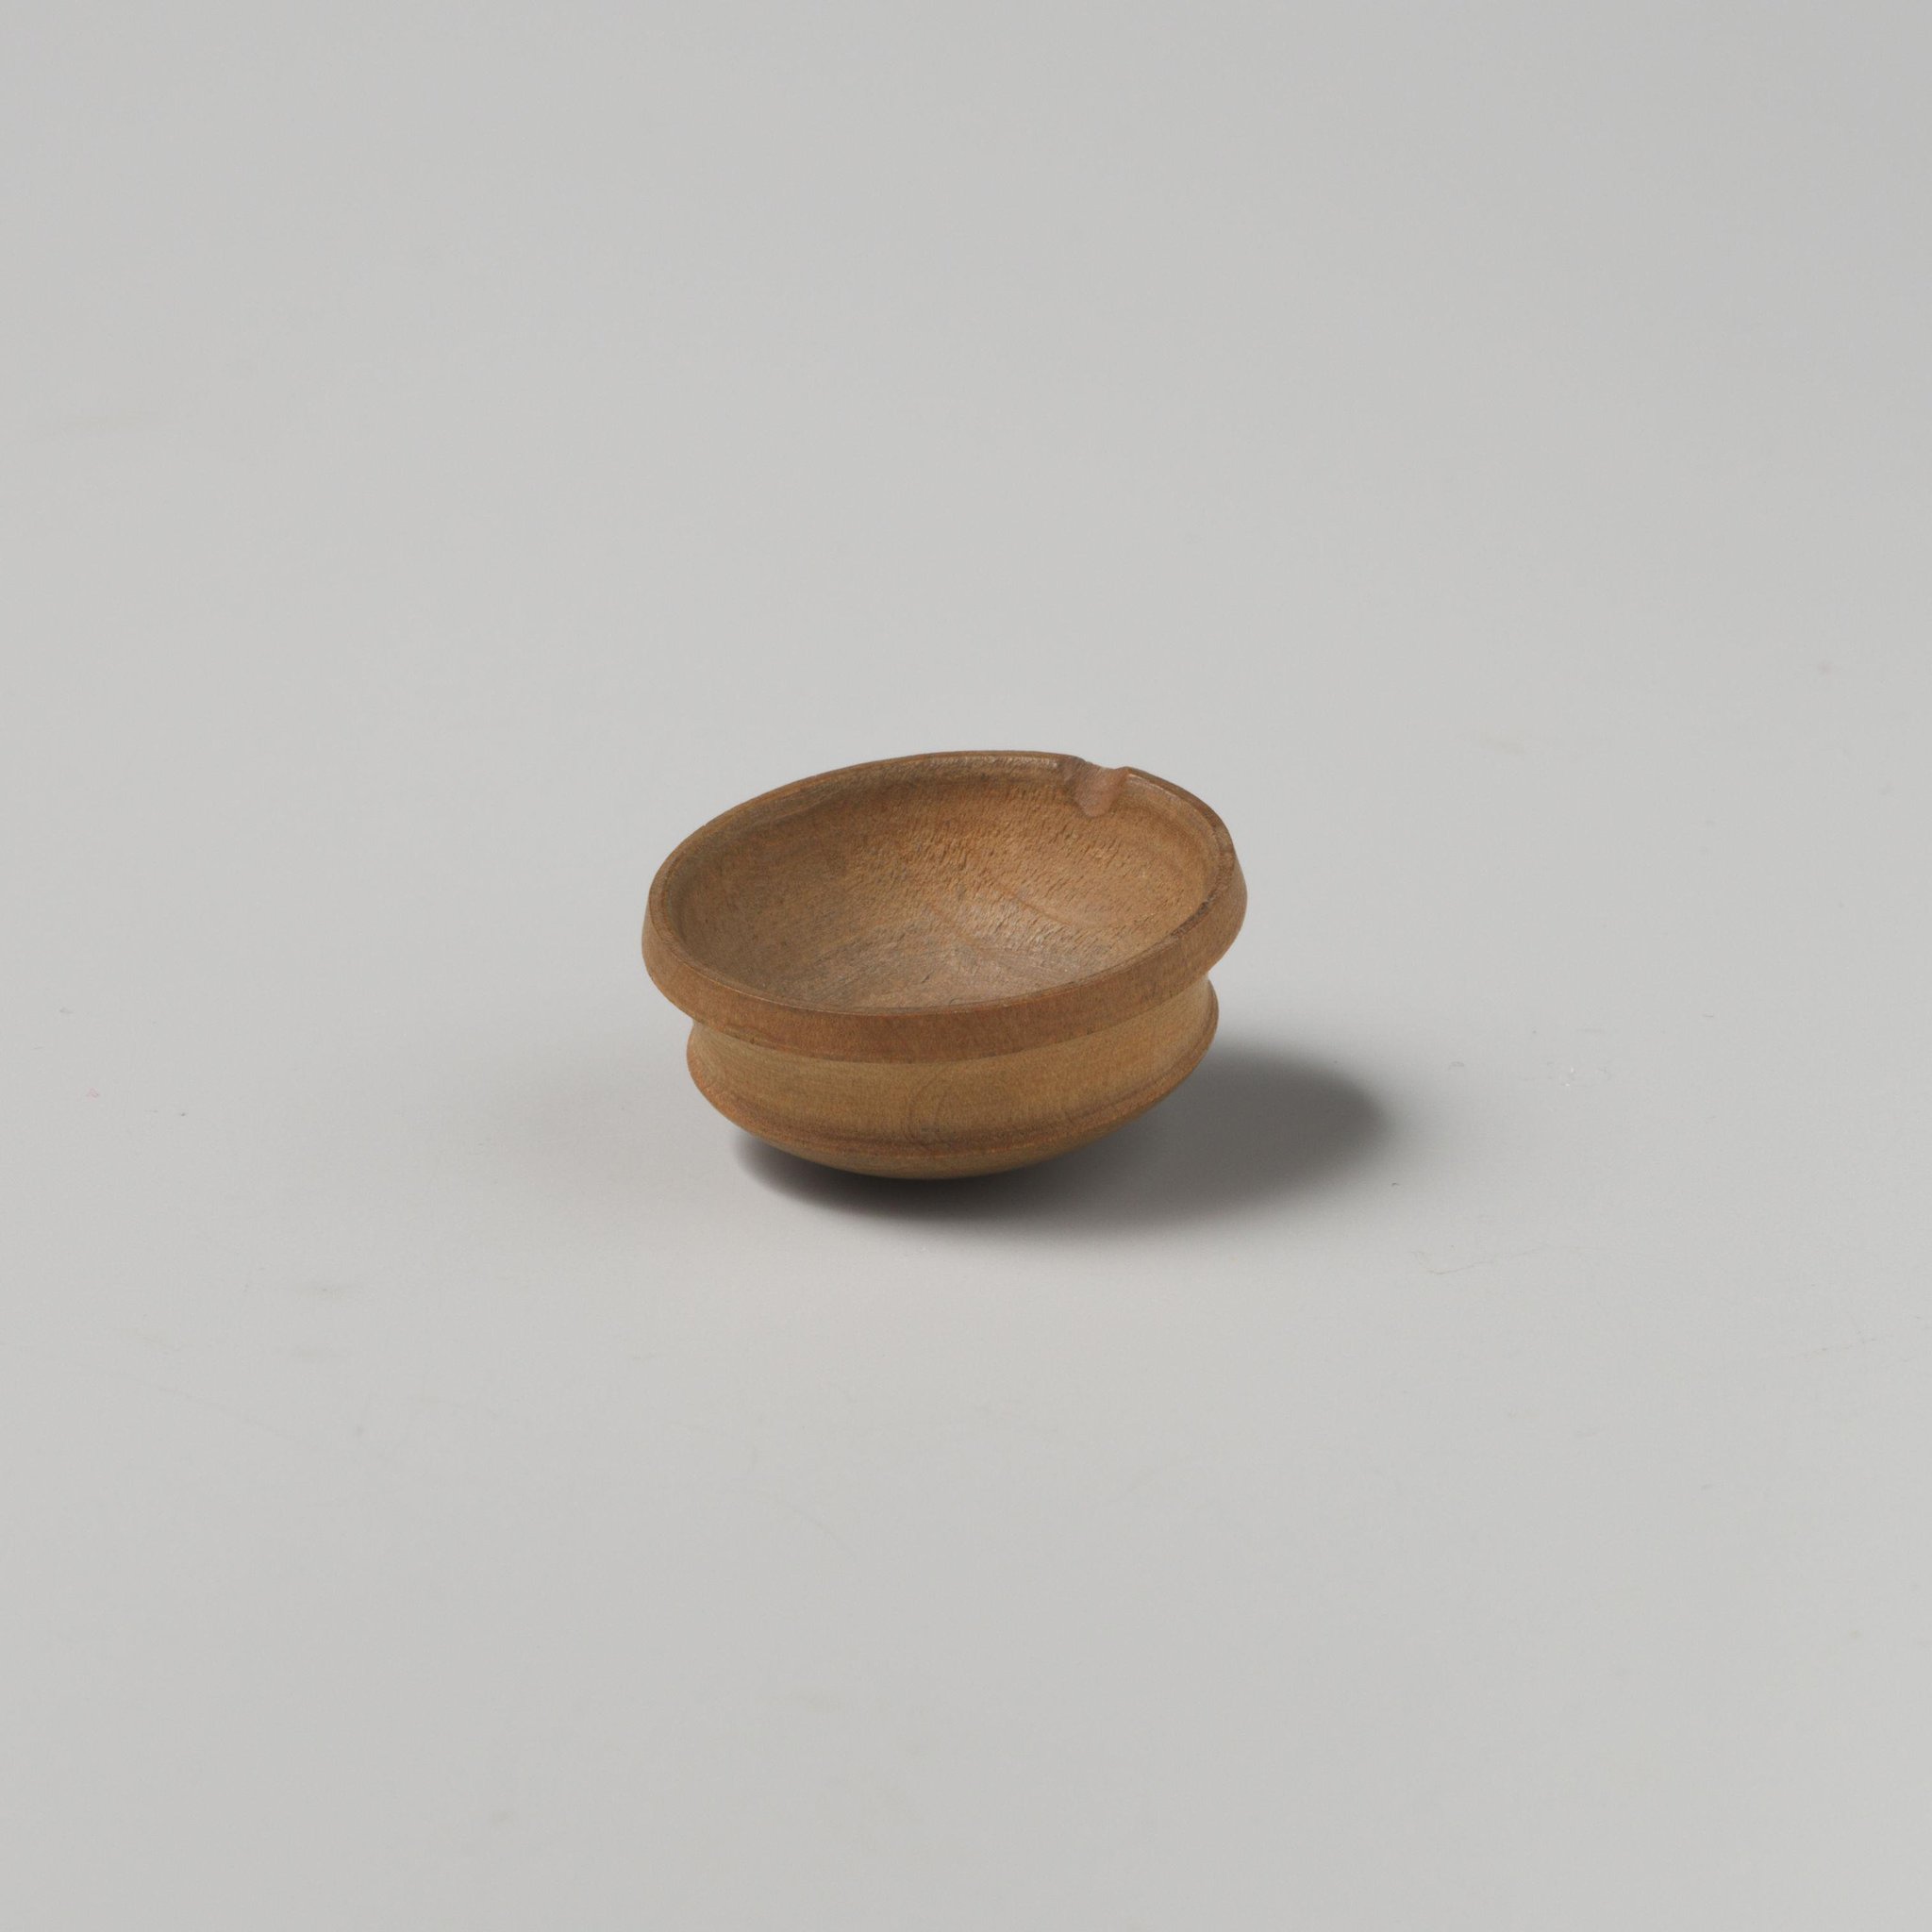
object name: miniature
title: Kom, gedraaid van esdoornhout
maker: Anonymous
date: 1675-1699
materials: wood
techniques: turning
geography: amsterdam